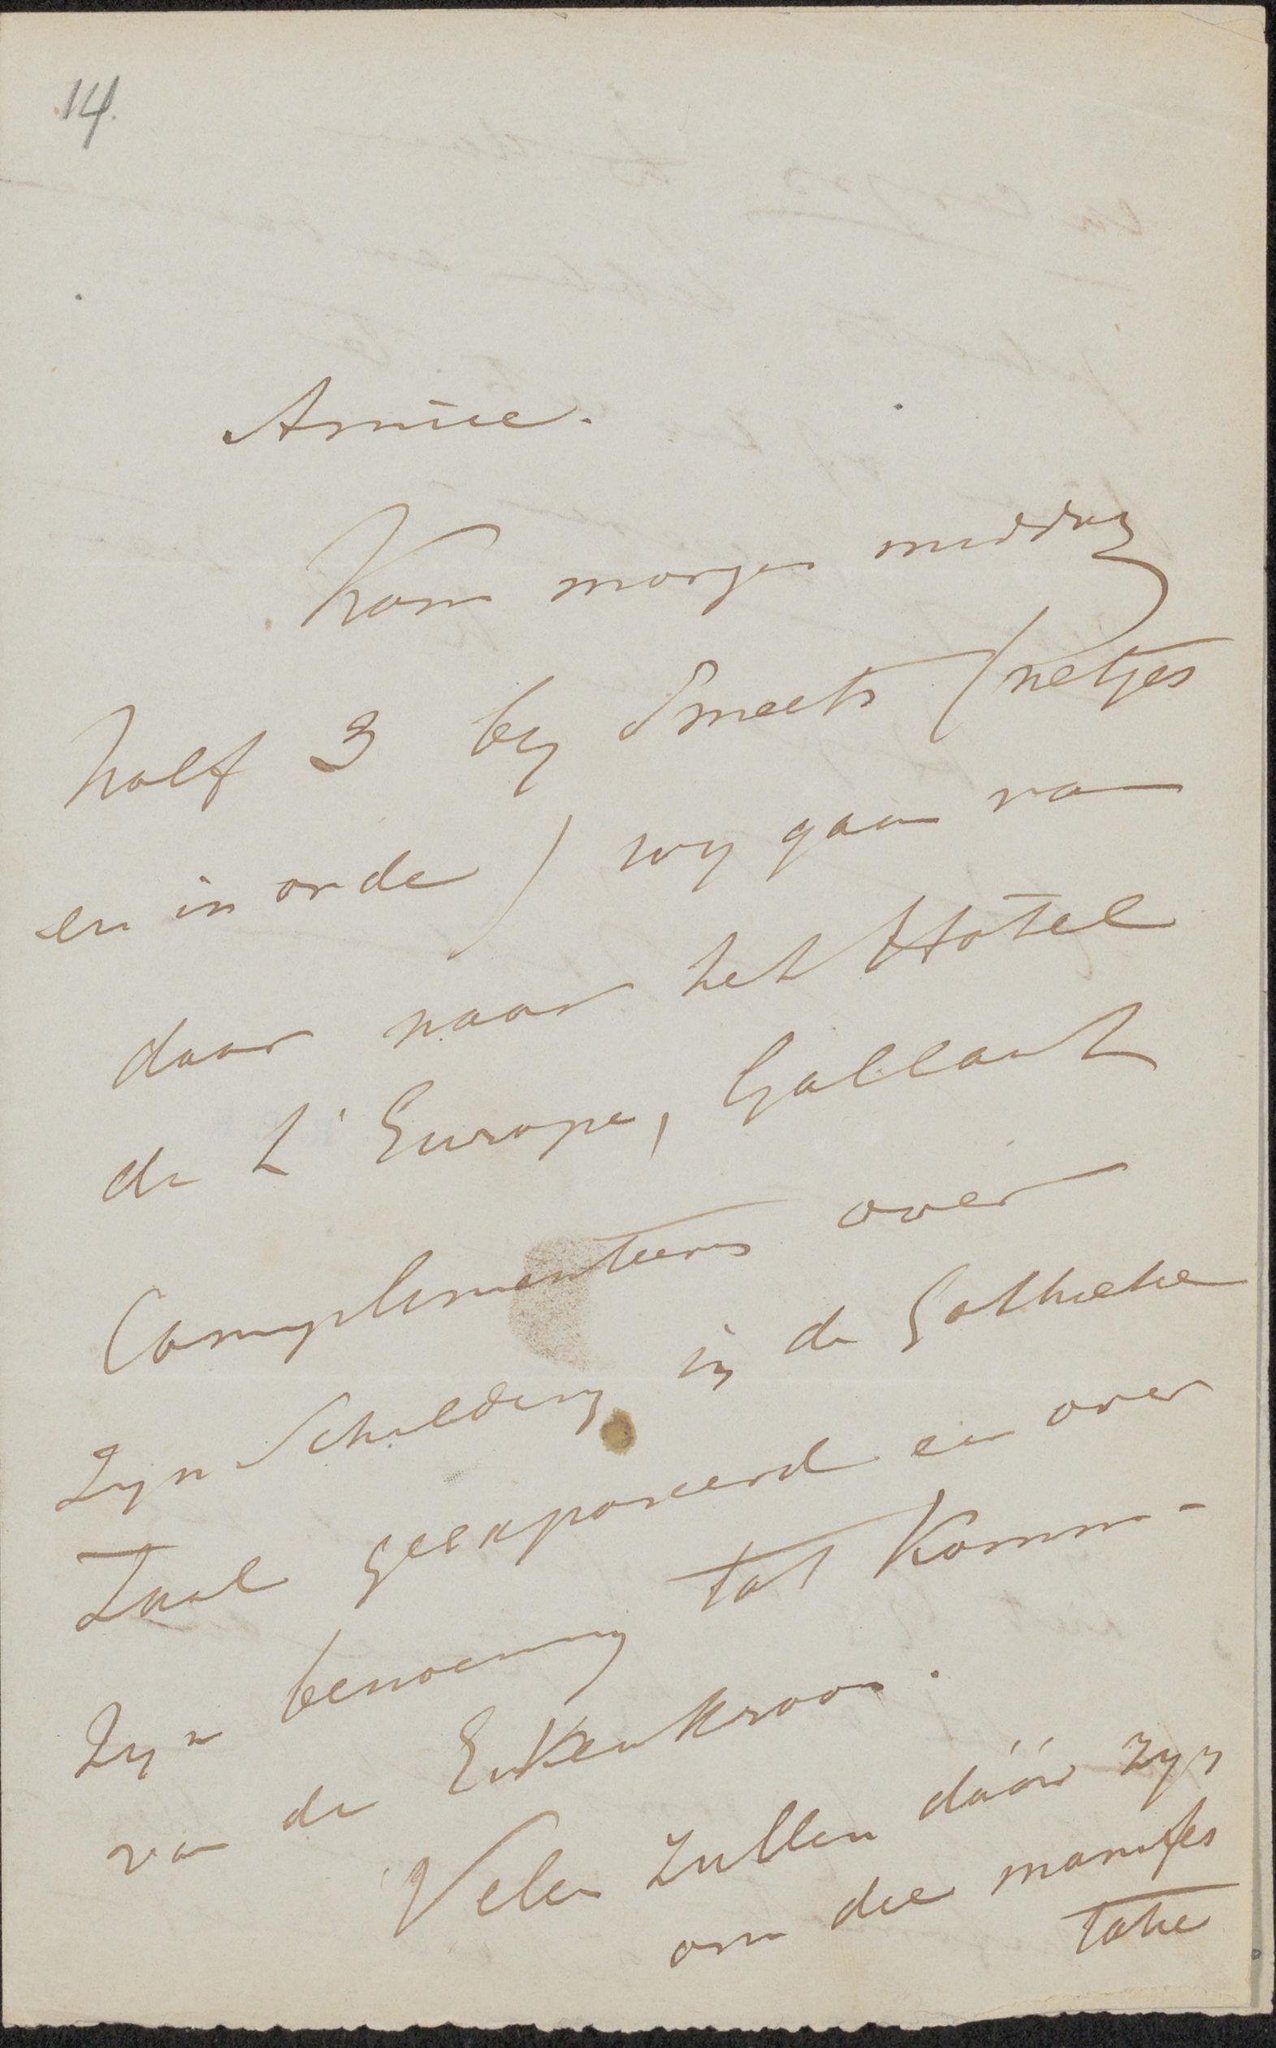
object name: letter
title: Brief aan Lambertus Hardenberg (1822-1900)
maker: johannes bosboom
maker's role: draughtsman, painter, print maker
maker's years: 1817-1891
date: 1827-1891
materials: ink, paper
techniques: pen, writing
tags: the hague, painter, print maker, jan weissenbruch, lambertus hardenberg (1822-1900), painting (including book-illumination, miniature-painting), amsterdam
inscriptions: collector's mark: Lugt 2233